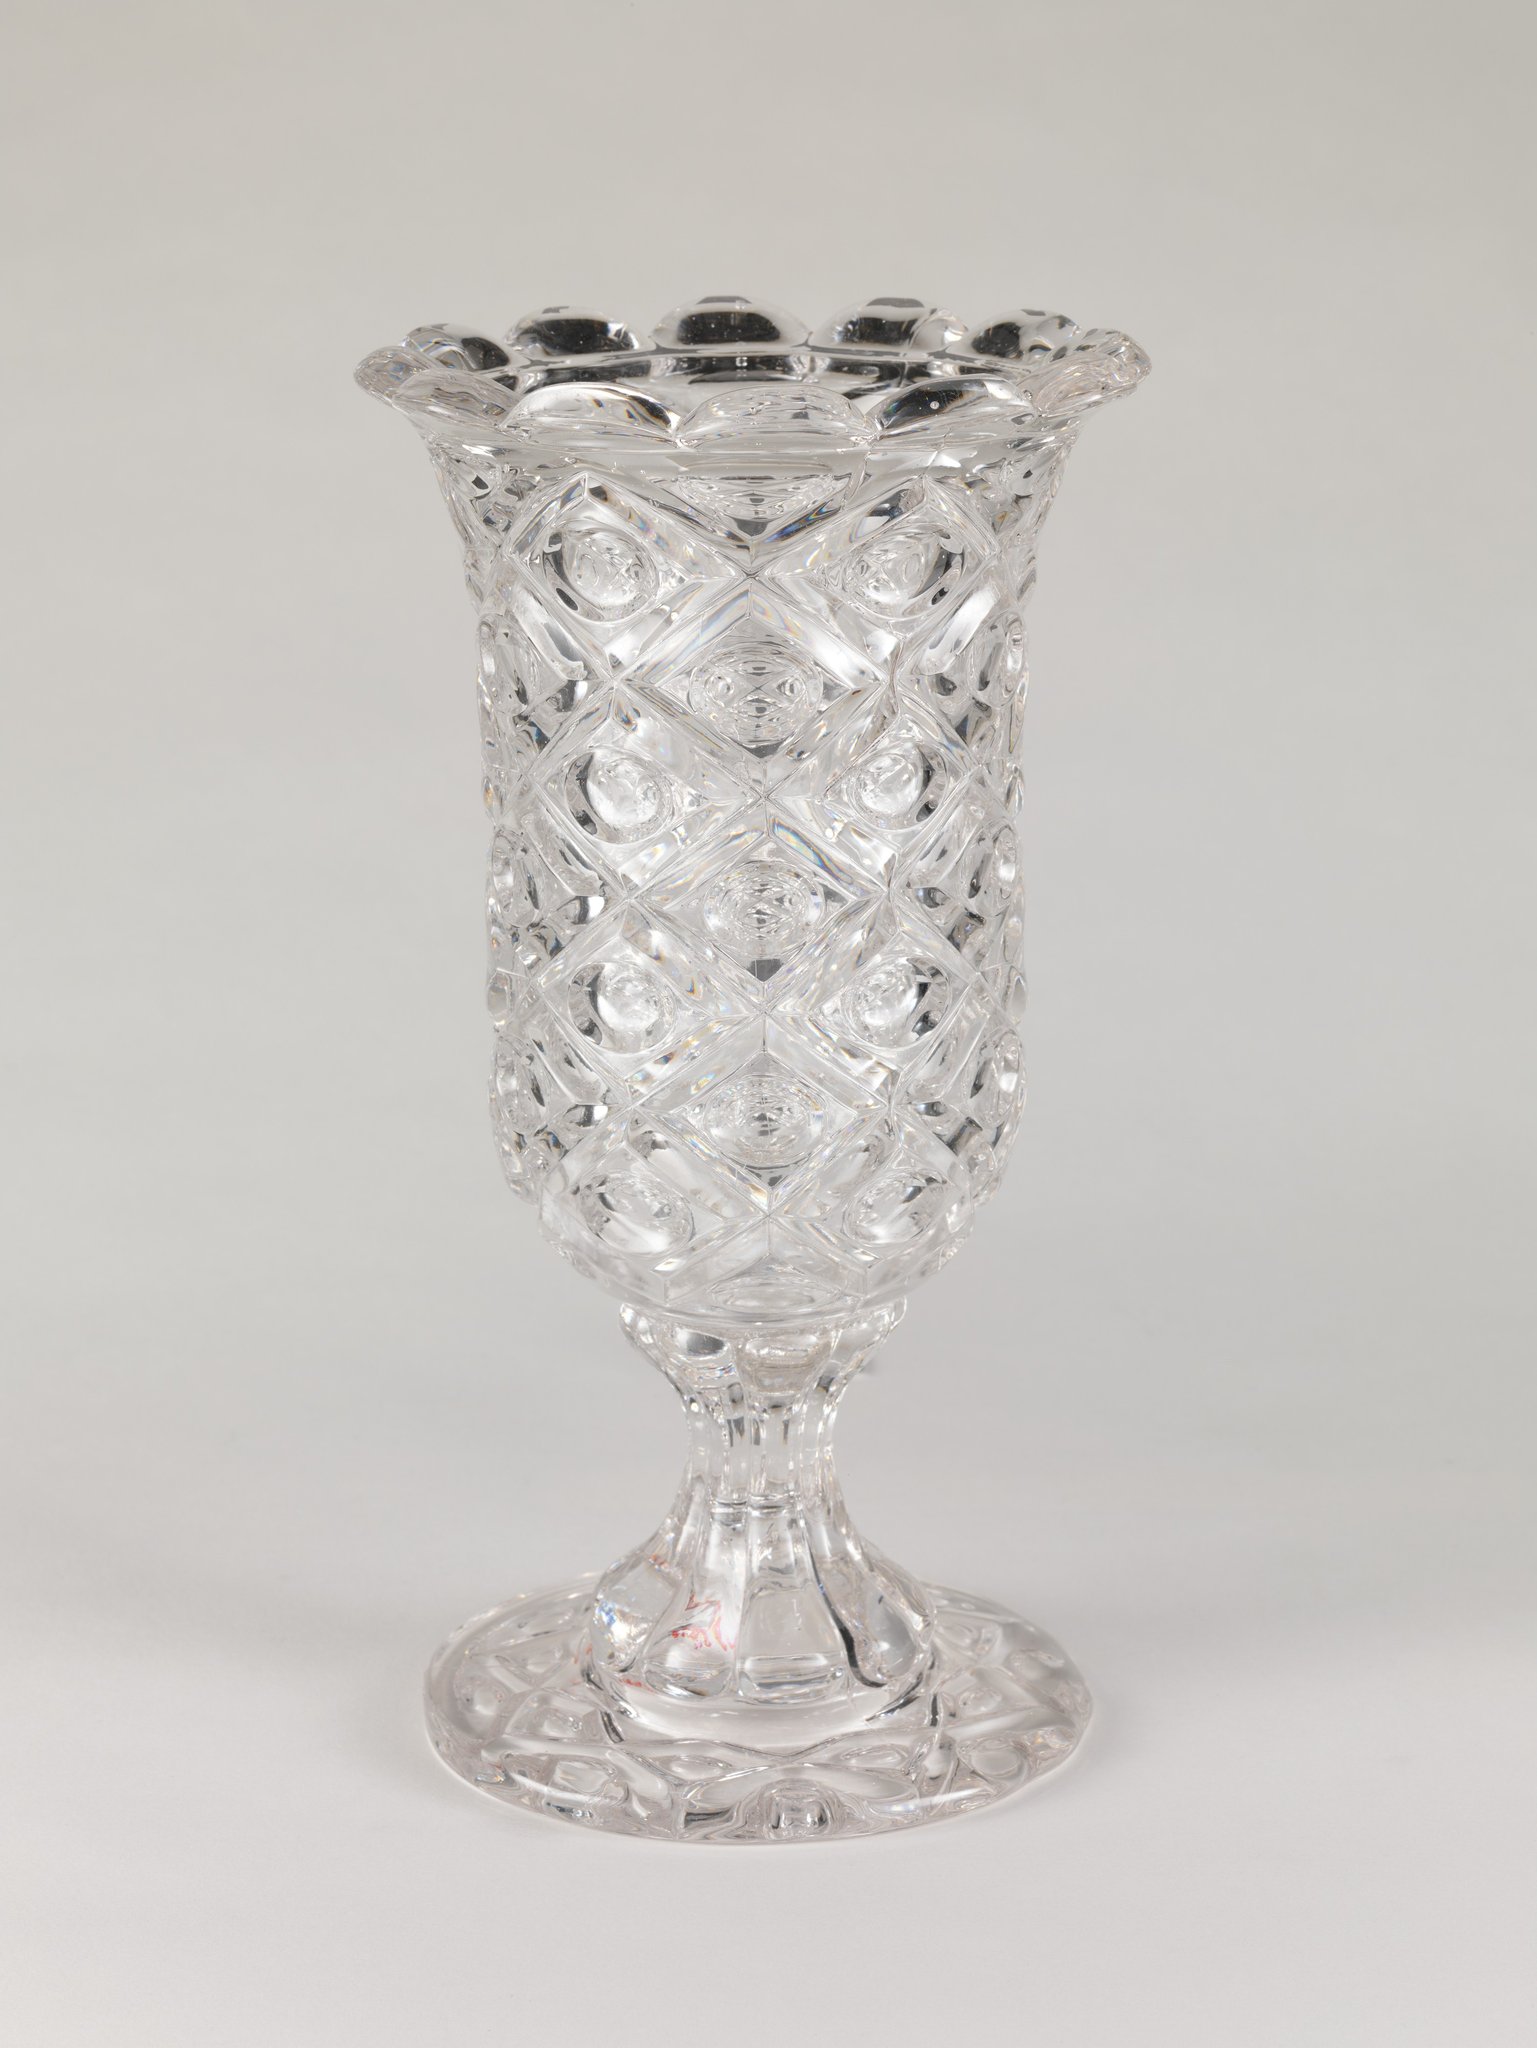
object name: celery vase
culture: american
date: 1850-1870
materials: diamond, glass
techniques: pressed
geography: united states